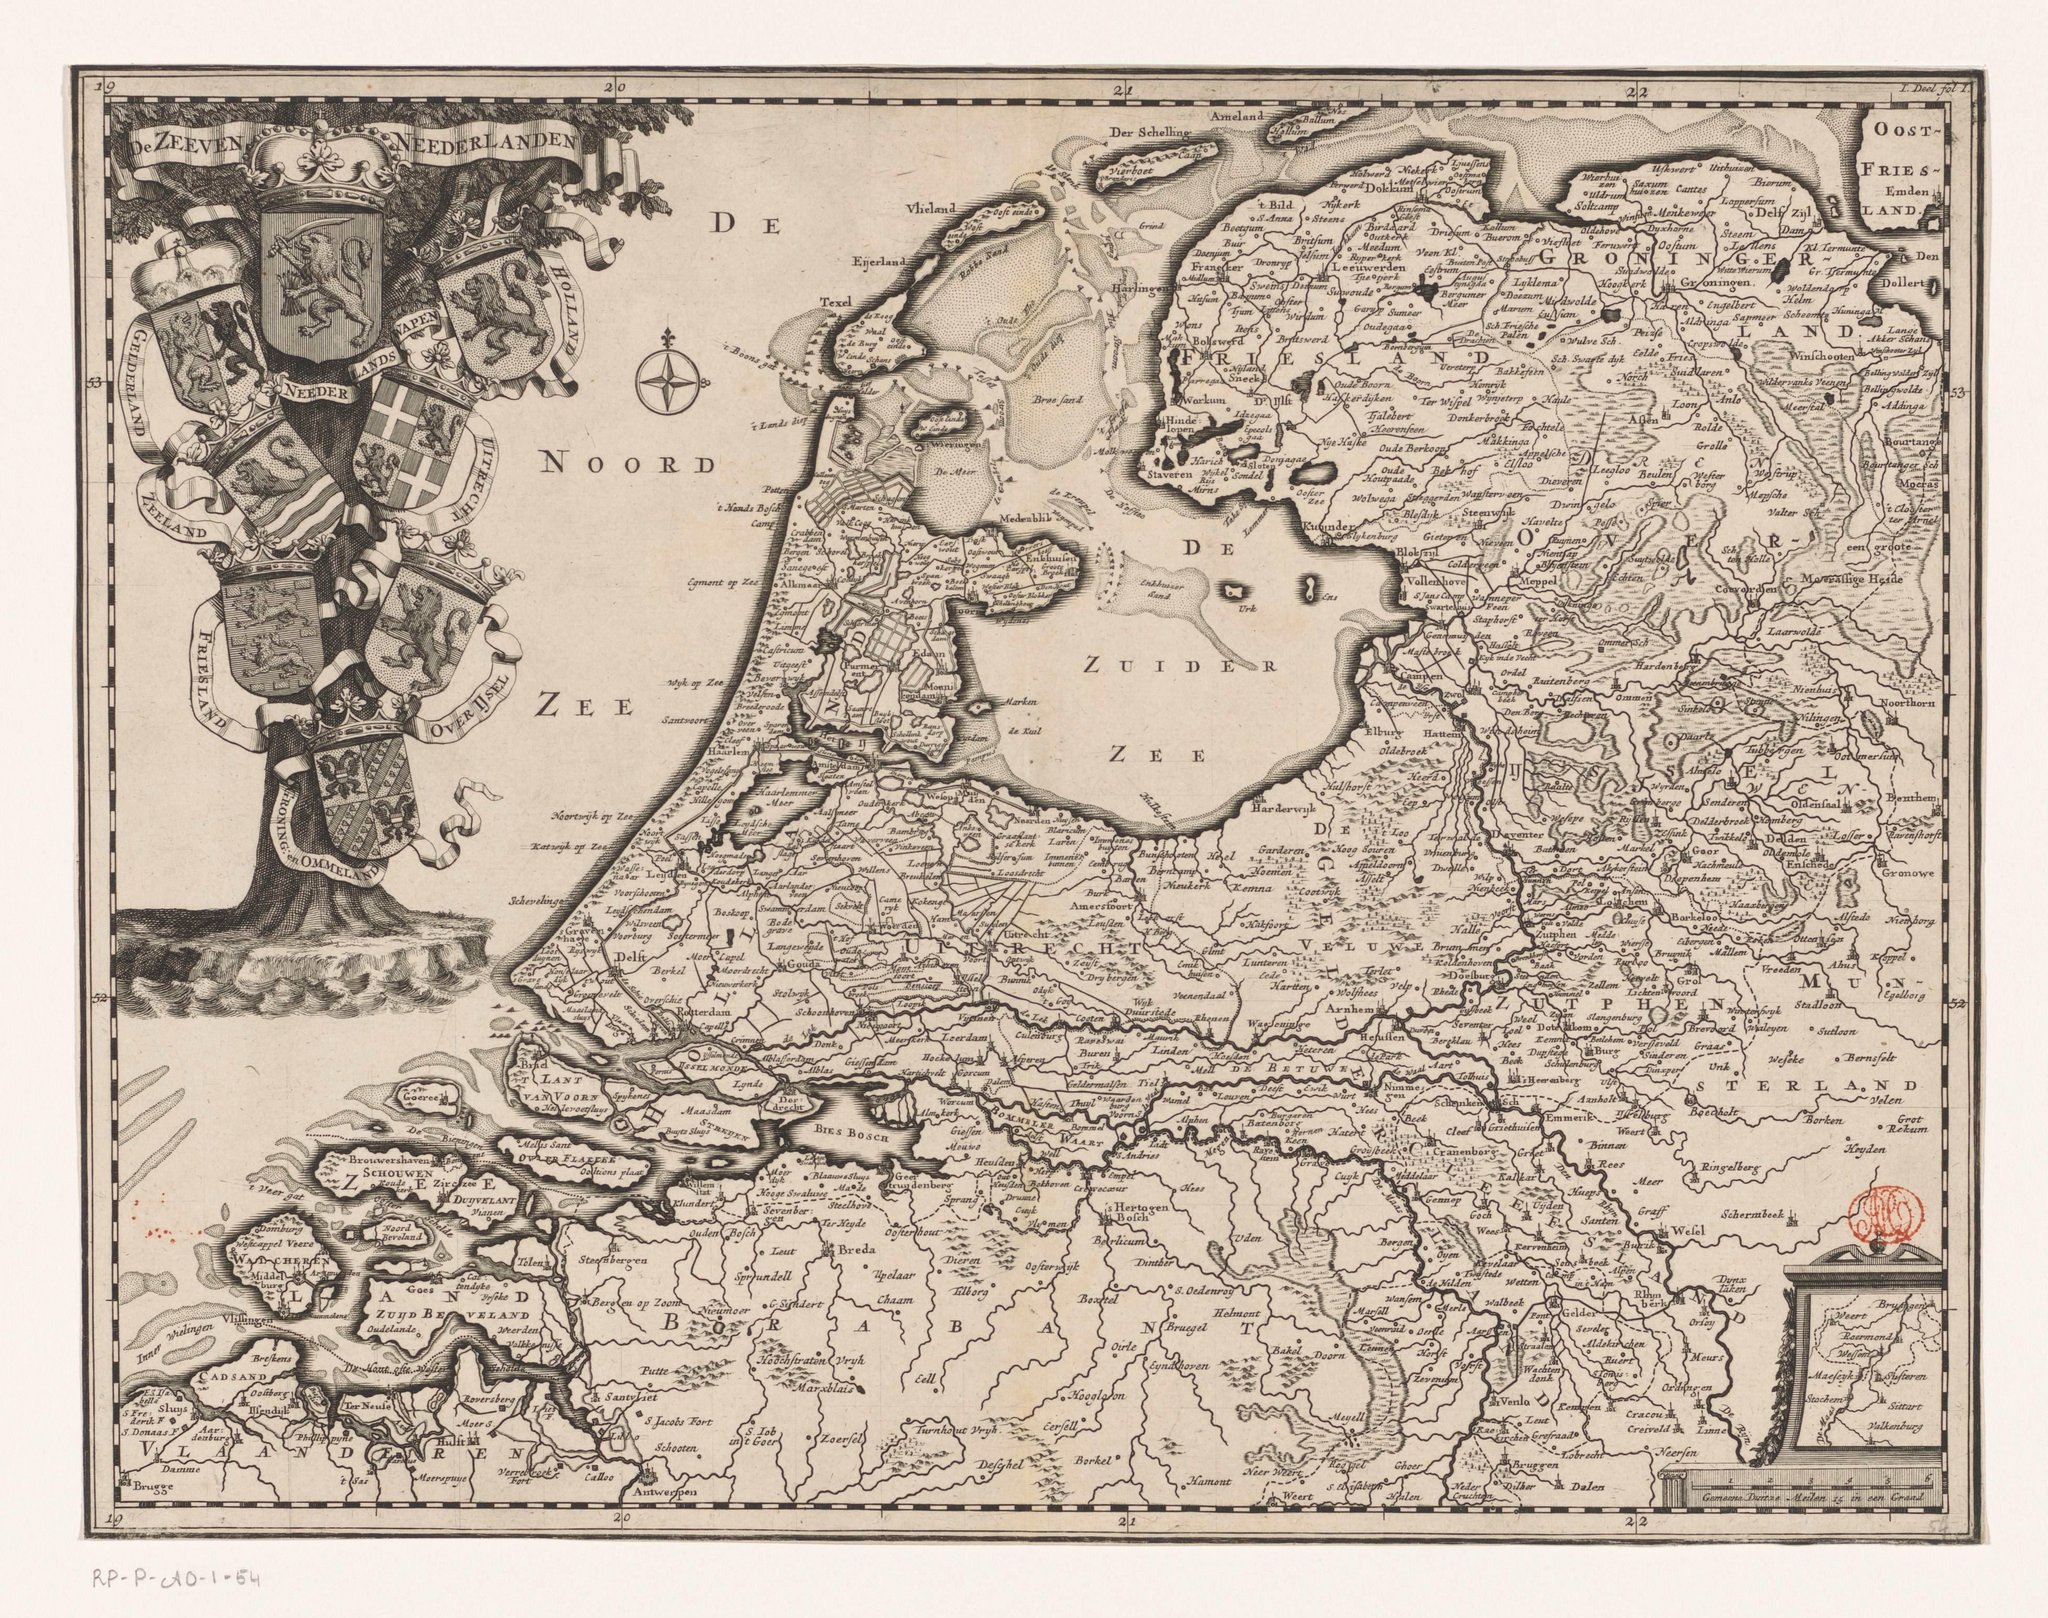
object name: print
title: De Zeeven Neederlanden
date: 1725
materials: paper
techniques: engraving, etching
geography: leeuwarden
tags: coat of arms (as symbol of the state, etc.), maps of separate countries or regions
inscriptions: collector's mark: Lugt 195, collector's mark: Lugt 2228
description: Links een boom met daarop de titel en de wapens van de Republiek en de Zeven Provinciën. Rechtsonder een inzetkaartje van een deel van het huidige Limburg (deel dat destijds tot Staats-Brabant behoorde). Daaronder schaalstok: Gemeene Duitze meilen 15 in een graad. Gradenverdeling langs de randen.